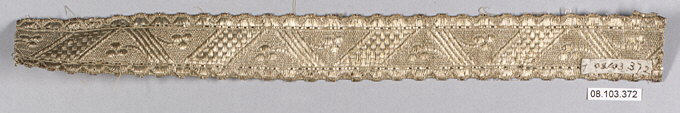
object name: galloon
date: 1601-1800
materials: metal thread